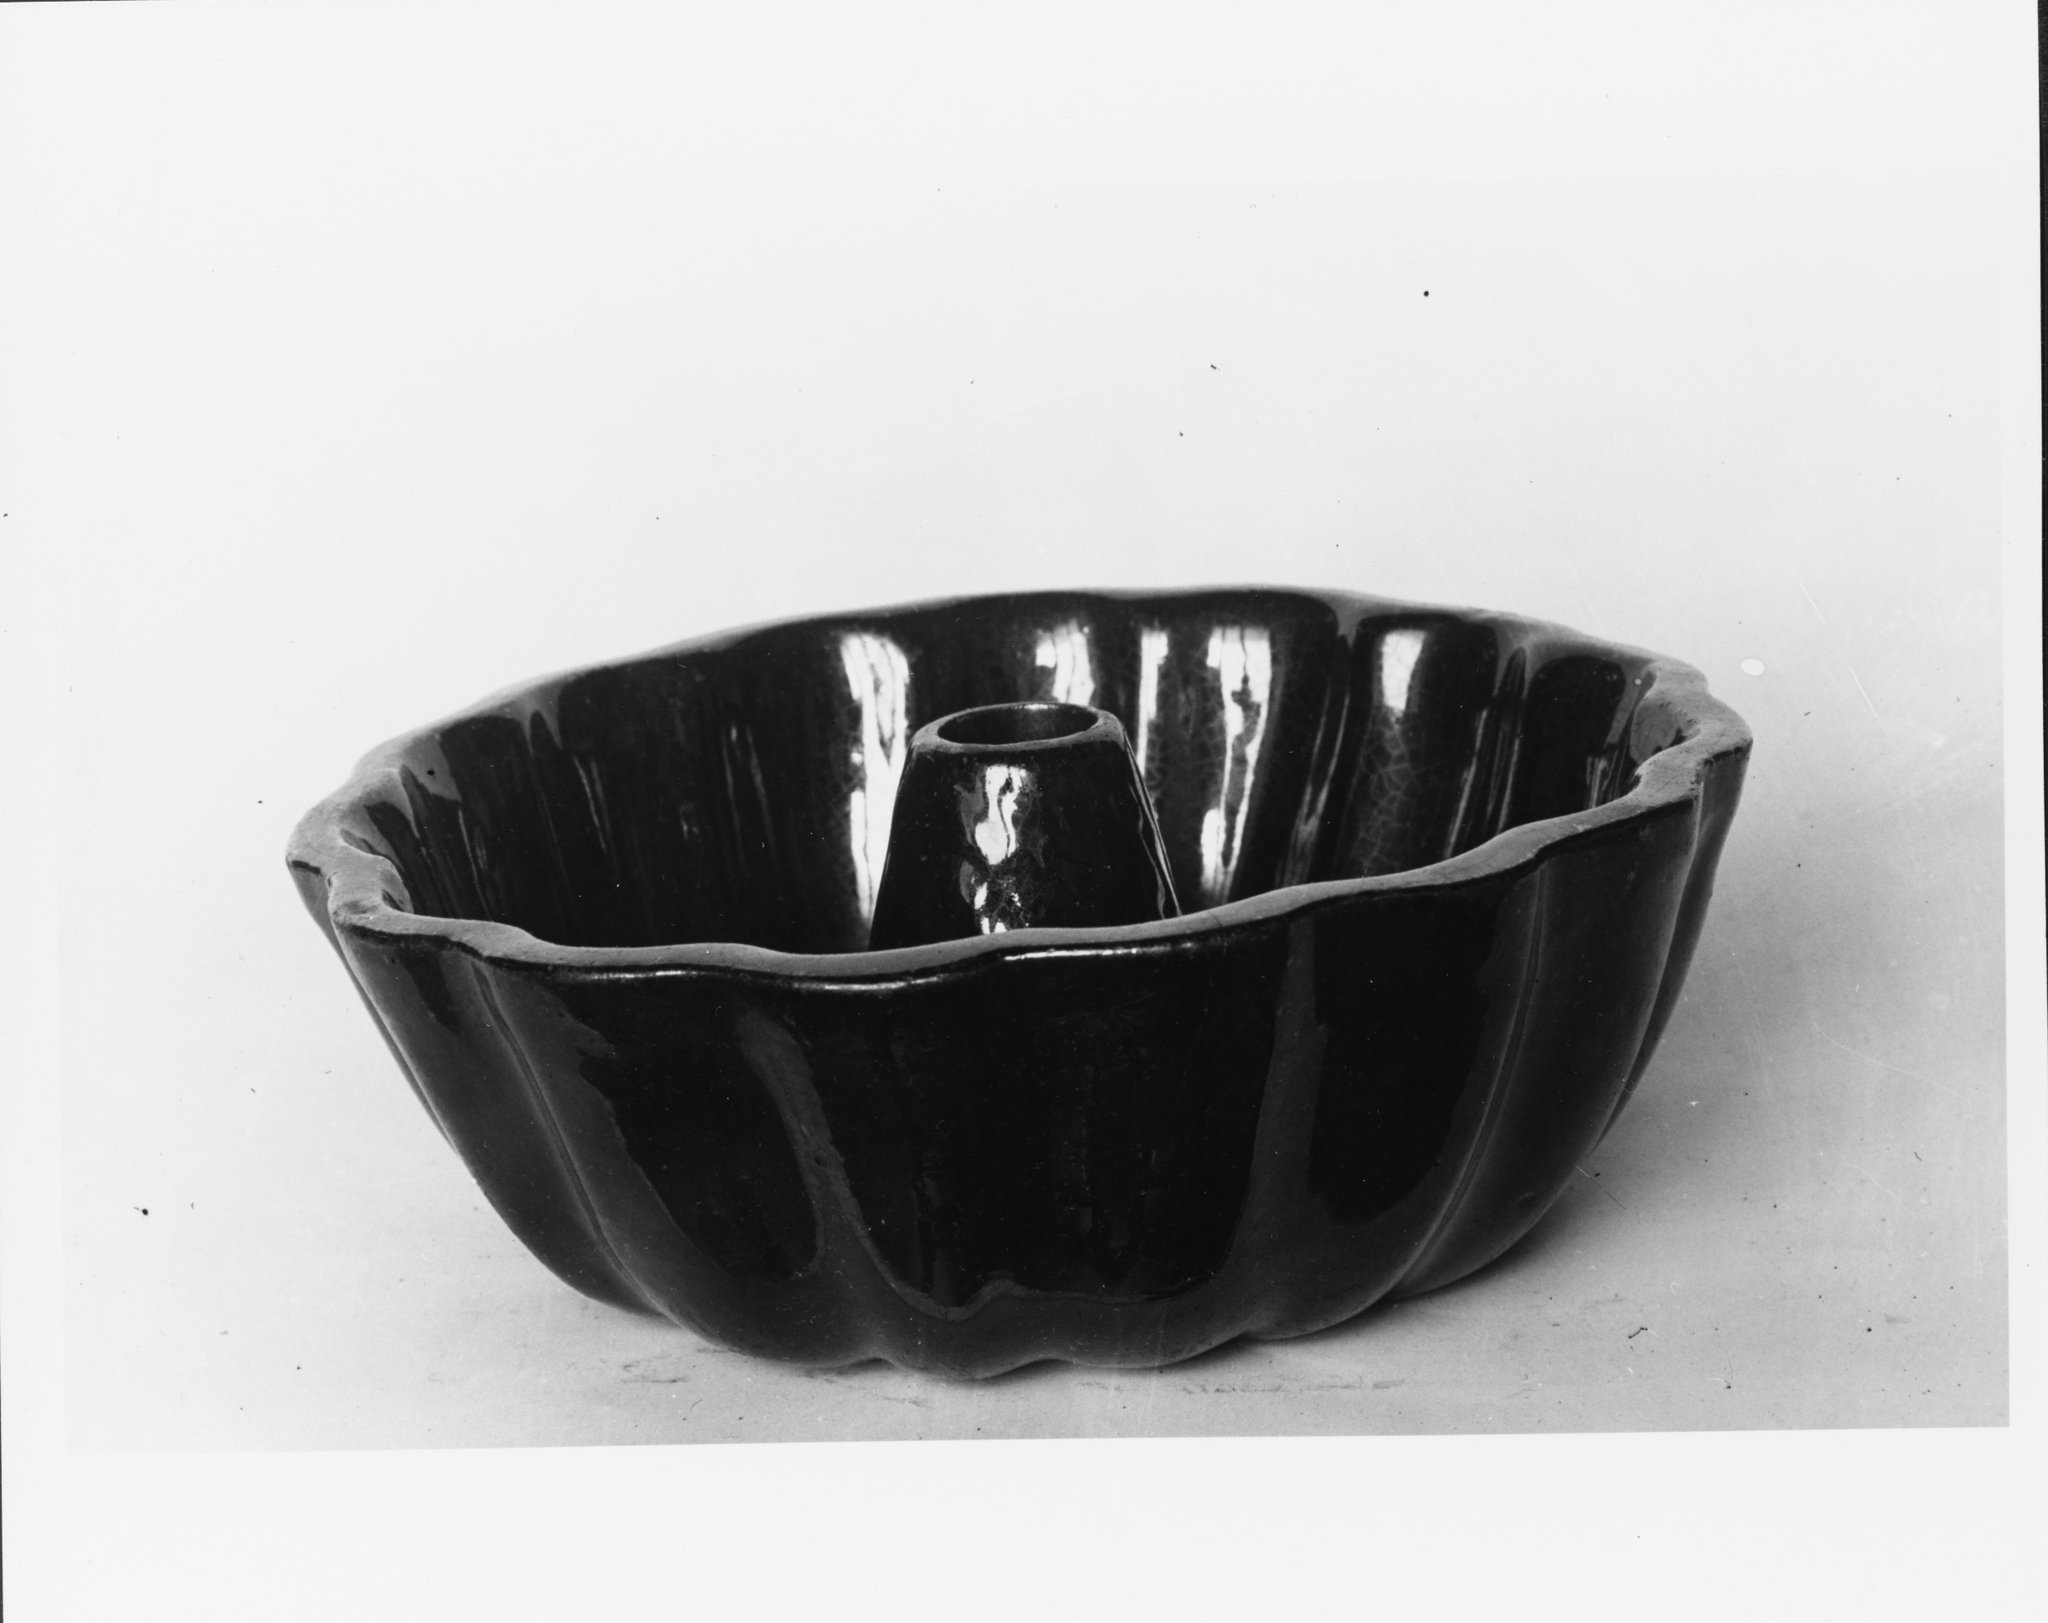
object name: dish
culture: american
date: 1800-1850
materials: earthenware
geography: united states